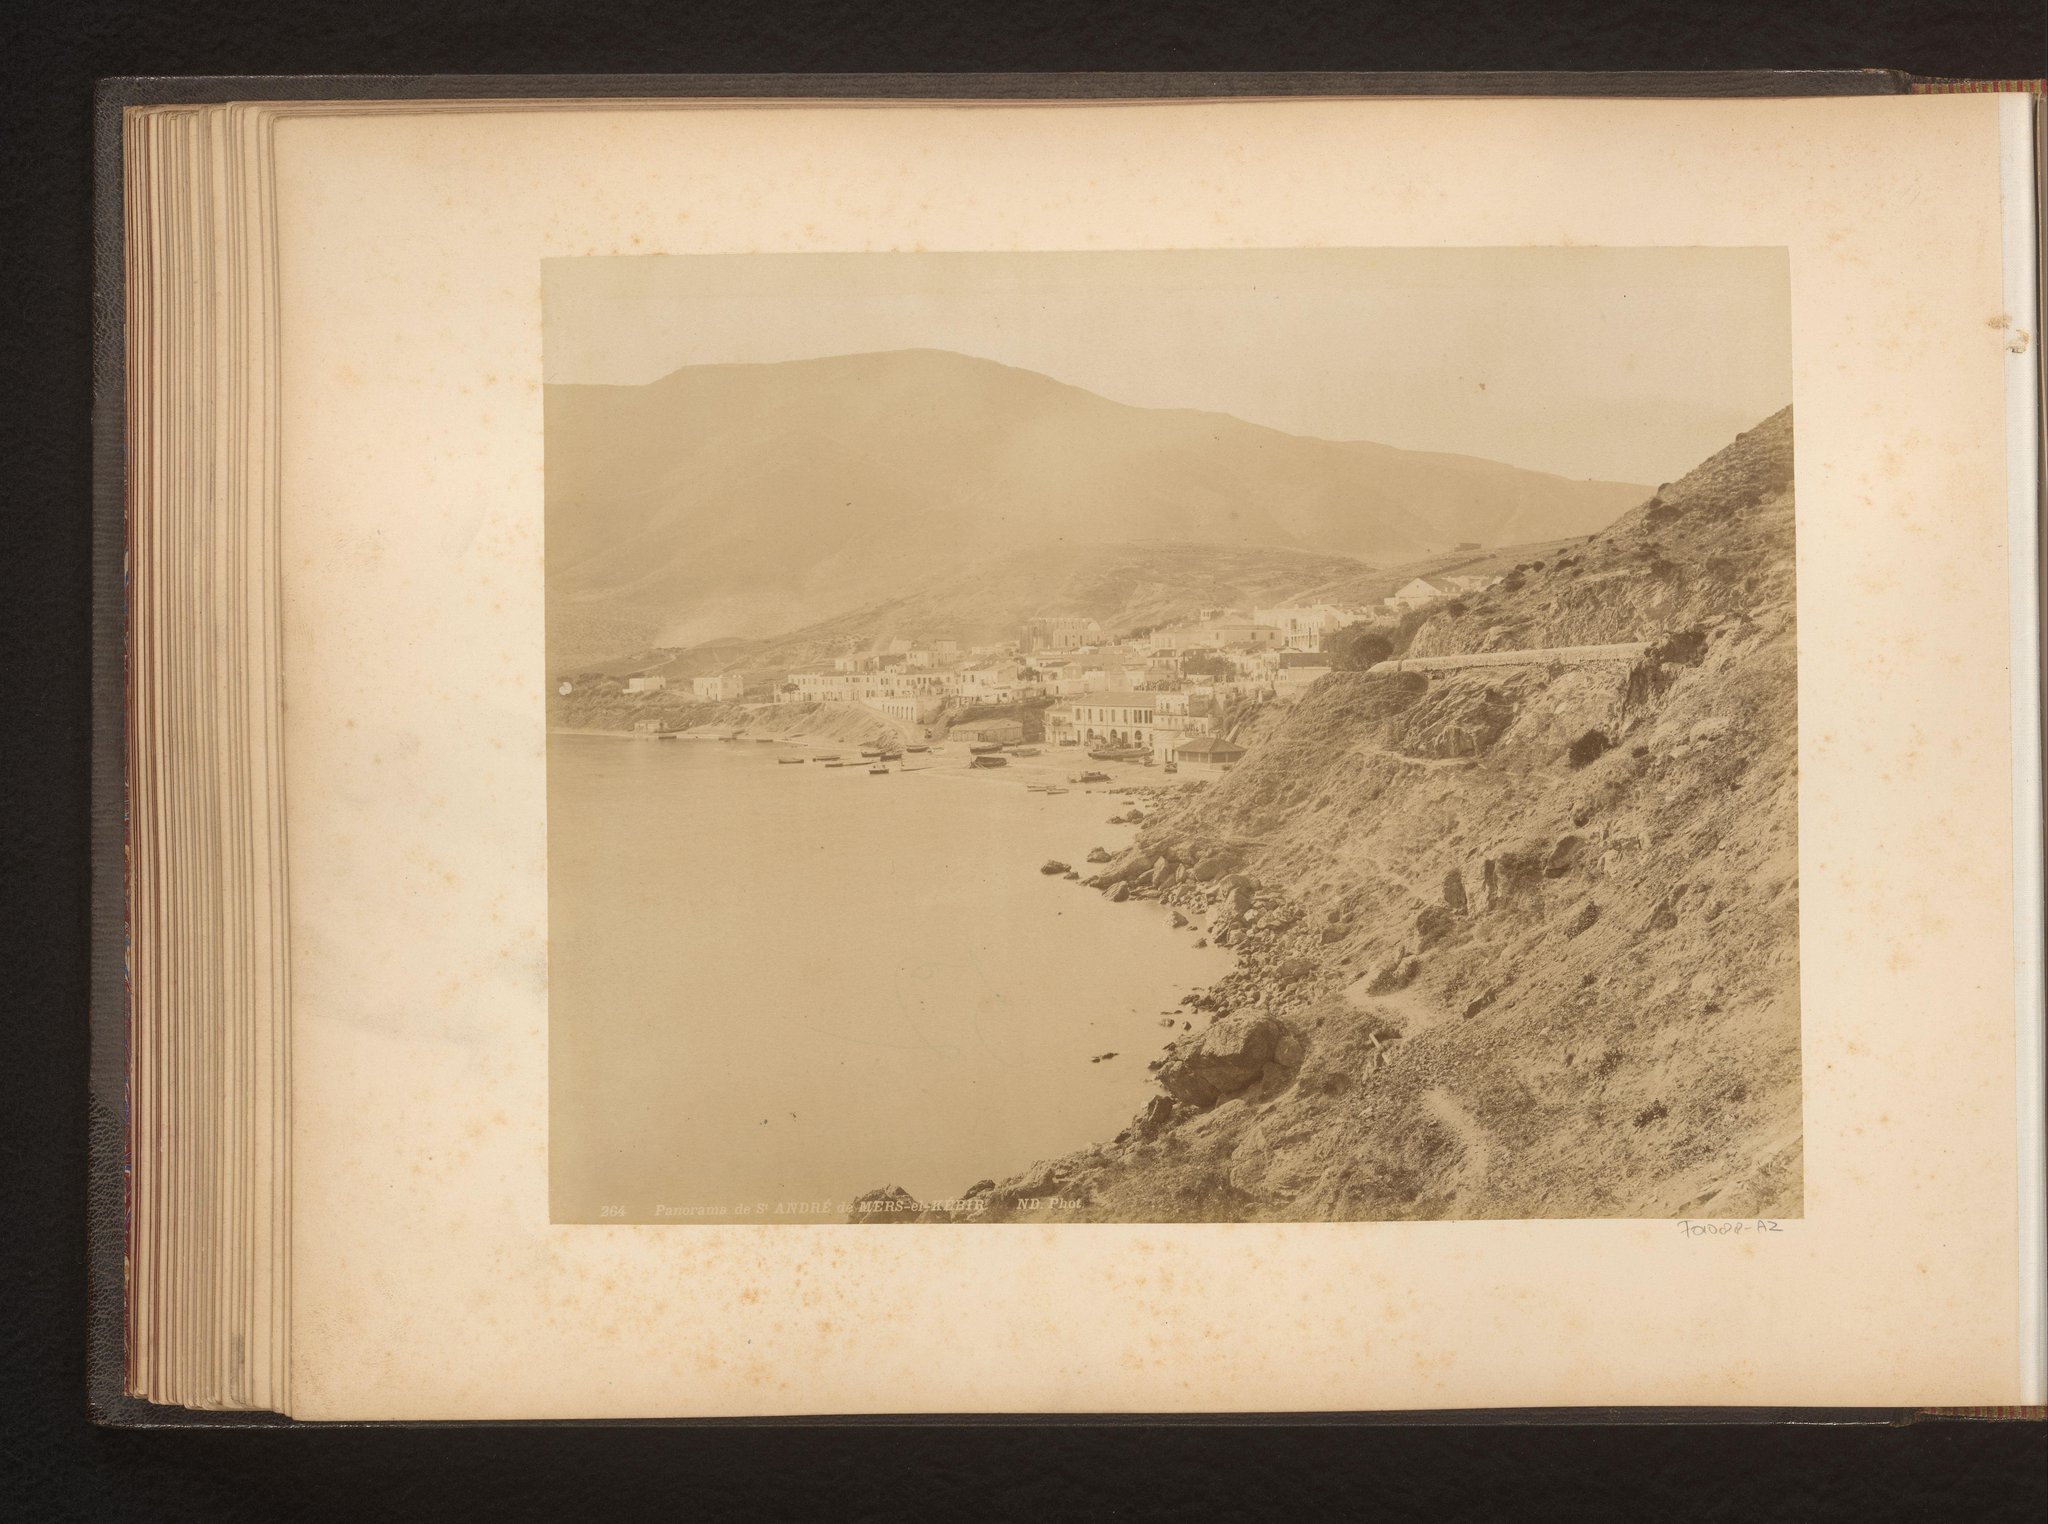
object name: album leaf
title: Panorama van Mers-el-Kébir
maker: étienne neurdein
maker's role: publisher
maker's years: 1832-1918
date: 1880-1900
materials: photographic support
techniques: albumen print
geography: mers-el-kébir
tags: landscapes with waters, waterscapes, seascapes (in the temperate zone), prospect of city, town panorama, silhouette of city, mountains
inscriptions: number: ‘264’